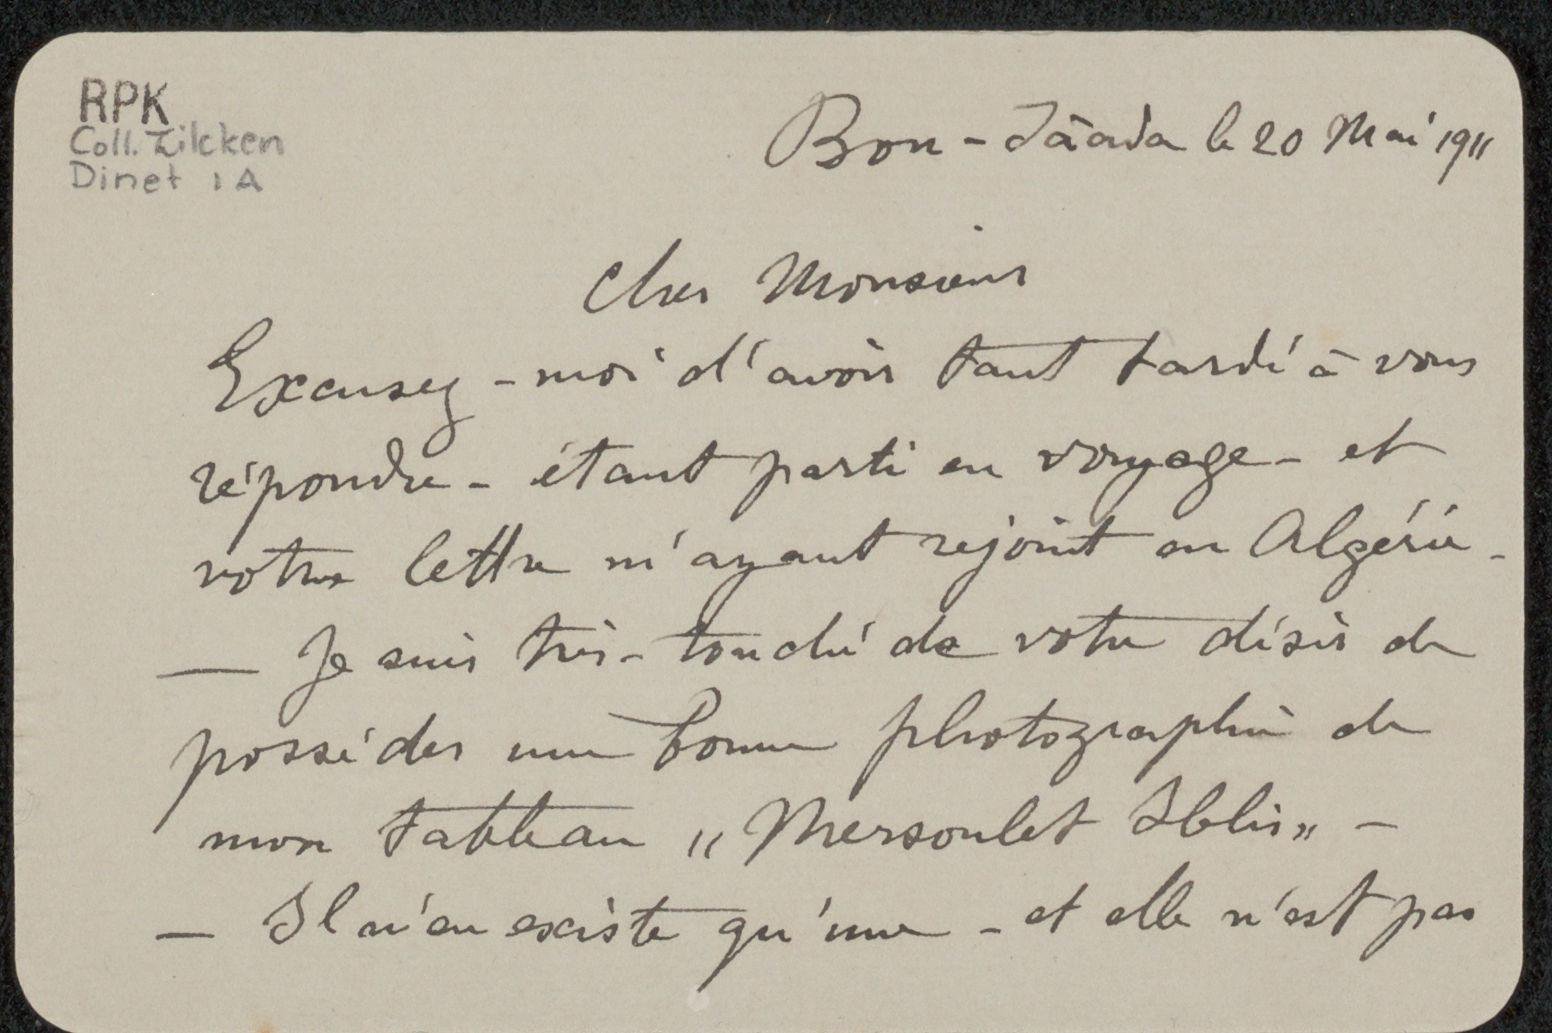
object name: letter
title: Brief aan Philip Zilcken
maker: etienne dinet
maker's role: draughtsman, painter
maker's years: 1861-1929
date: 1911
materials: cardboard, ink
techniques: pen, writing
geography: bou saâda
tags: painter, draughtsman, philip zilcken, photography, cinematography, painting (including book-illumination, miniature-painting), paris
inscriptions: collector's mark: ‘RPK’